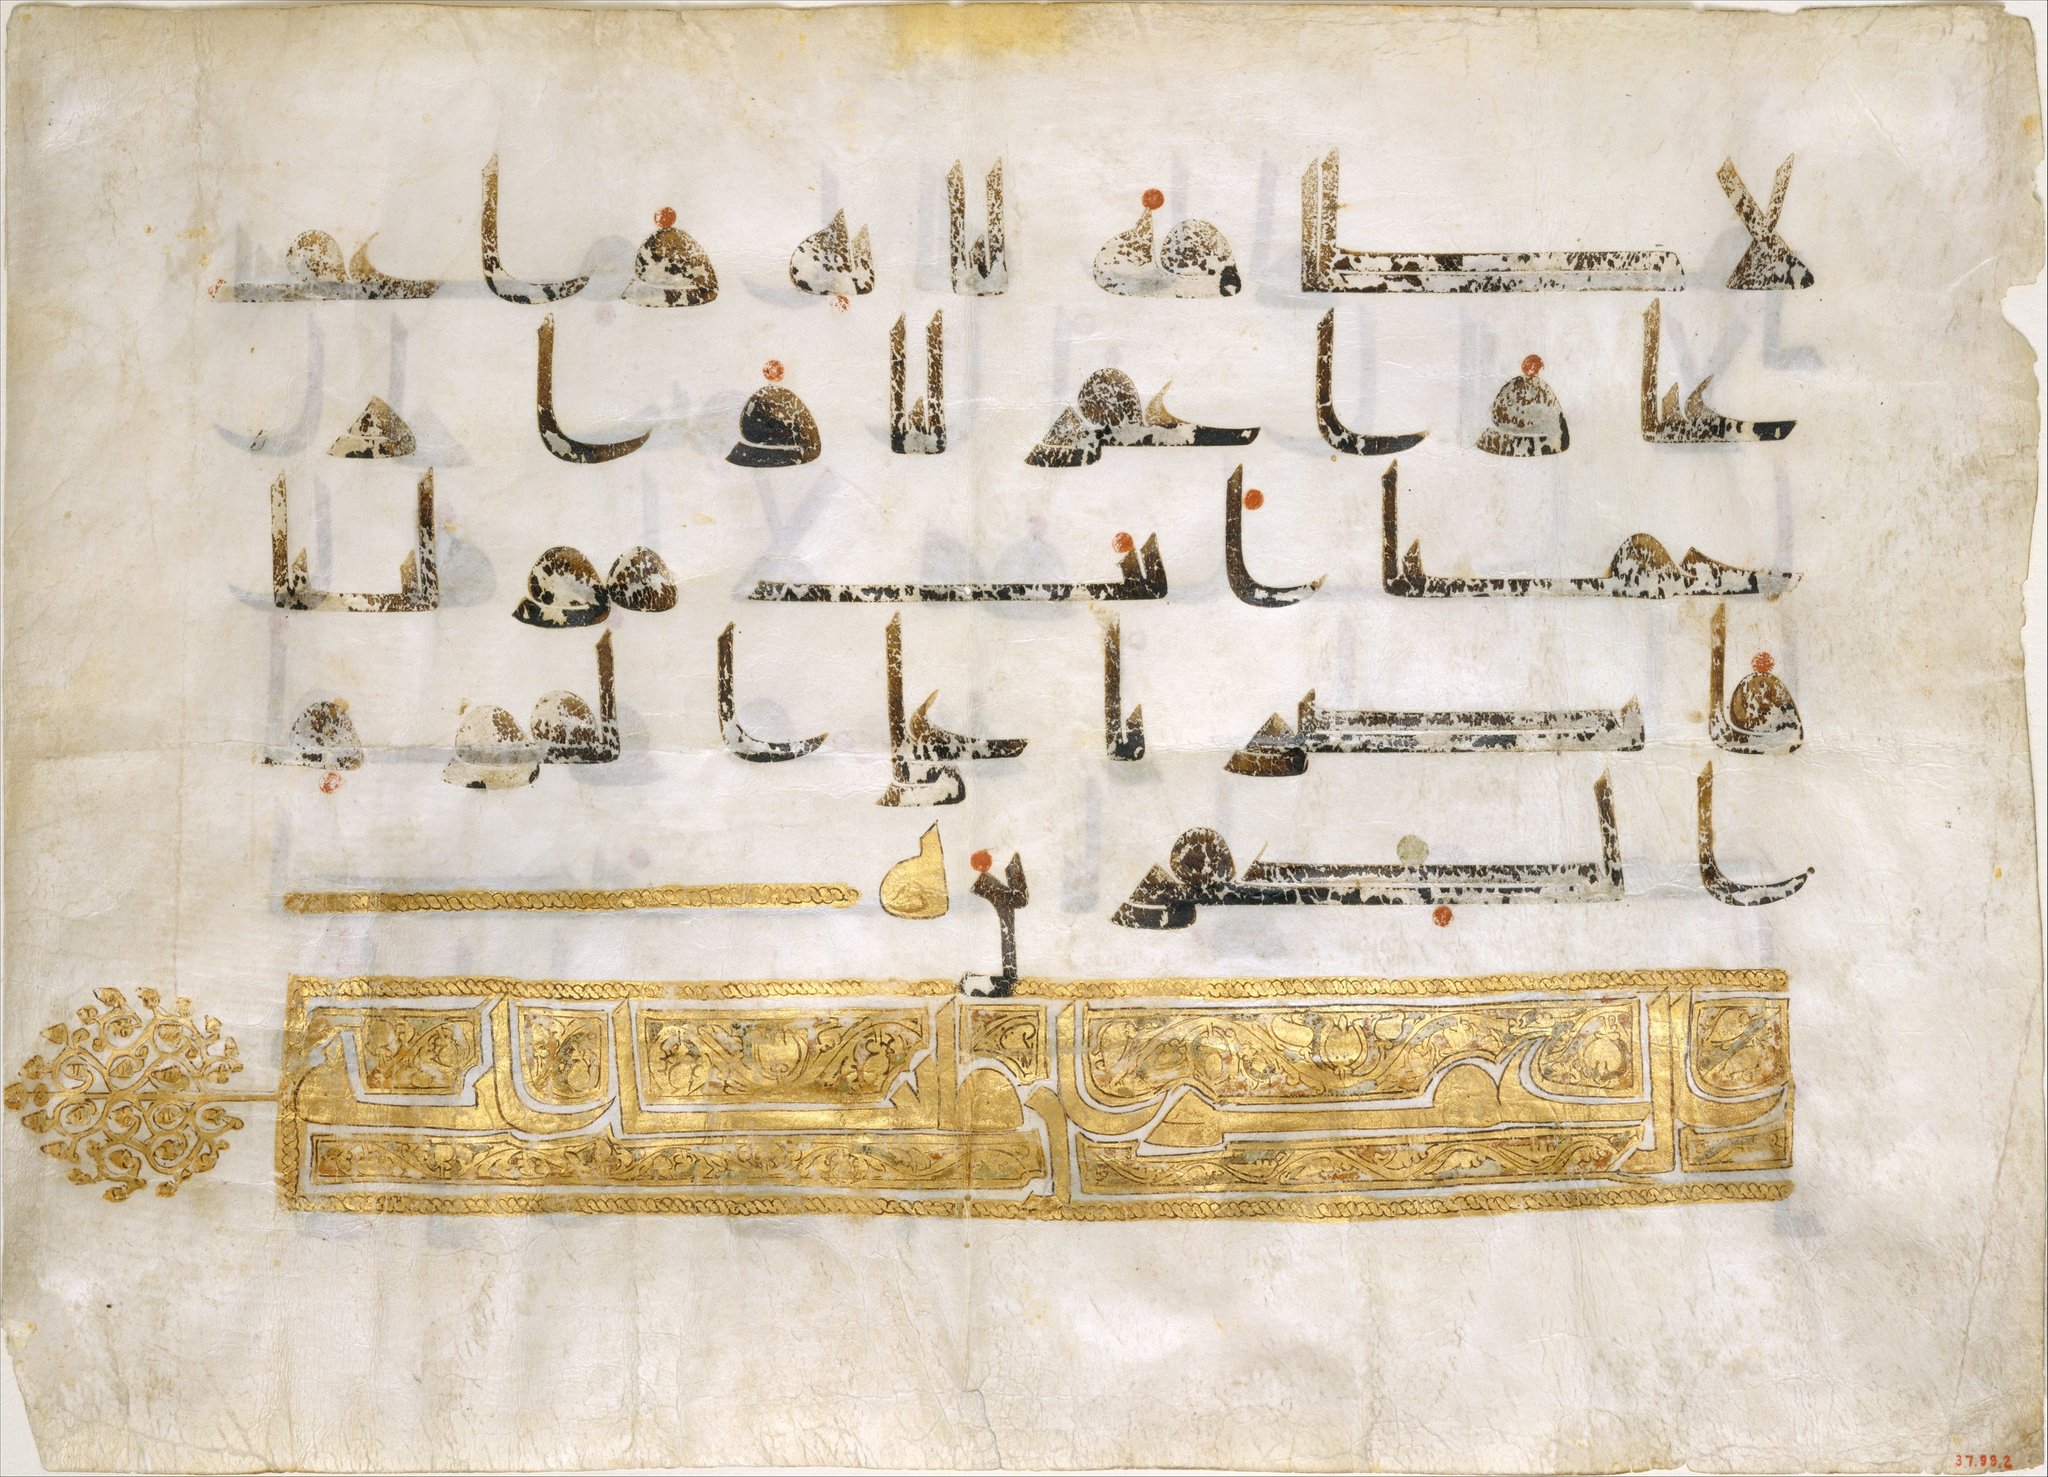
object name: folio from a non illustrated manuscript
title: Folio from a Qur'an Manuscript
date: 801-1000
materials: gold, ink, parchment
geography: central islamic lands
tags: arabic,qur'an,calligraphy